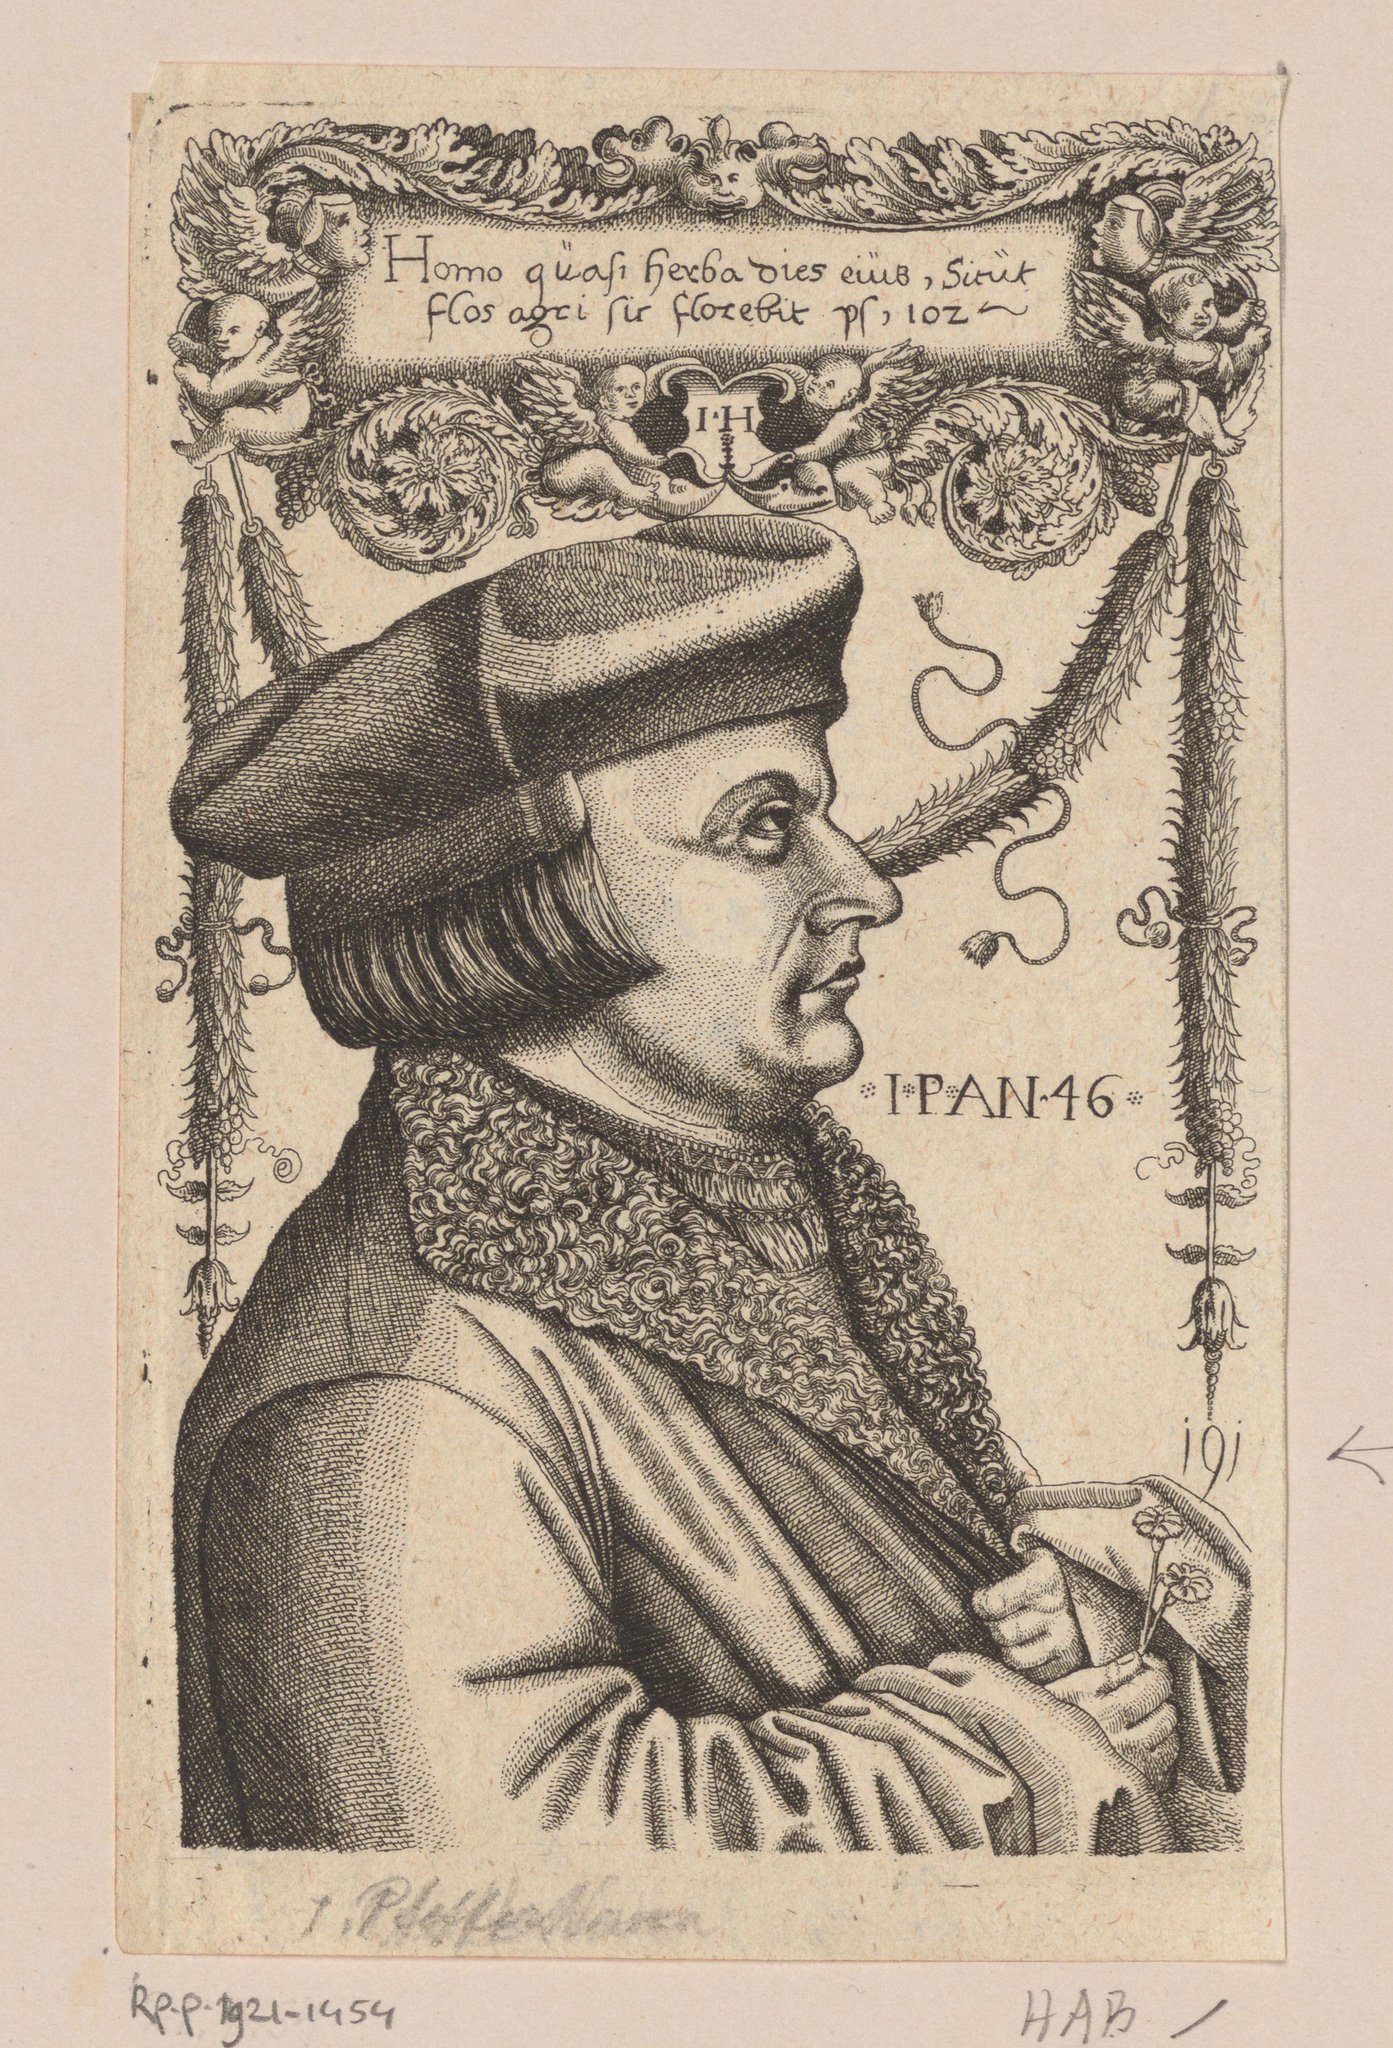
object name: print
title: Portret van Johann Pfefferkorn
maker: hieronymus hopfer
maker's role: print maker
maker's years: 1500-1550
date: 1525-1699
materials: paper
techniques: engraving, etching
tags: adult woman, historical persons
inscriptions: collector's mark: Lugt 2233